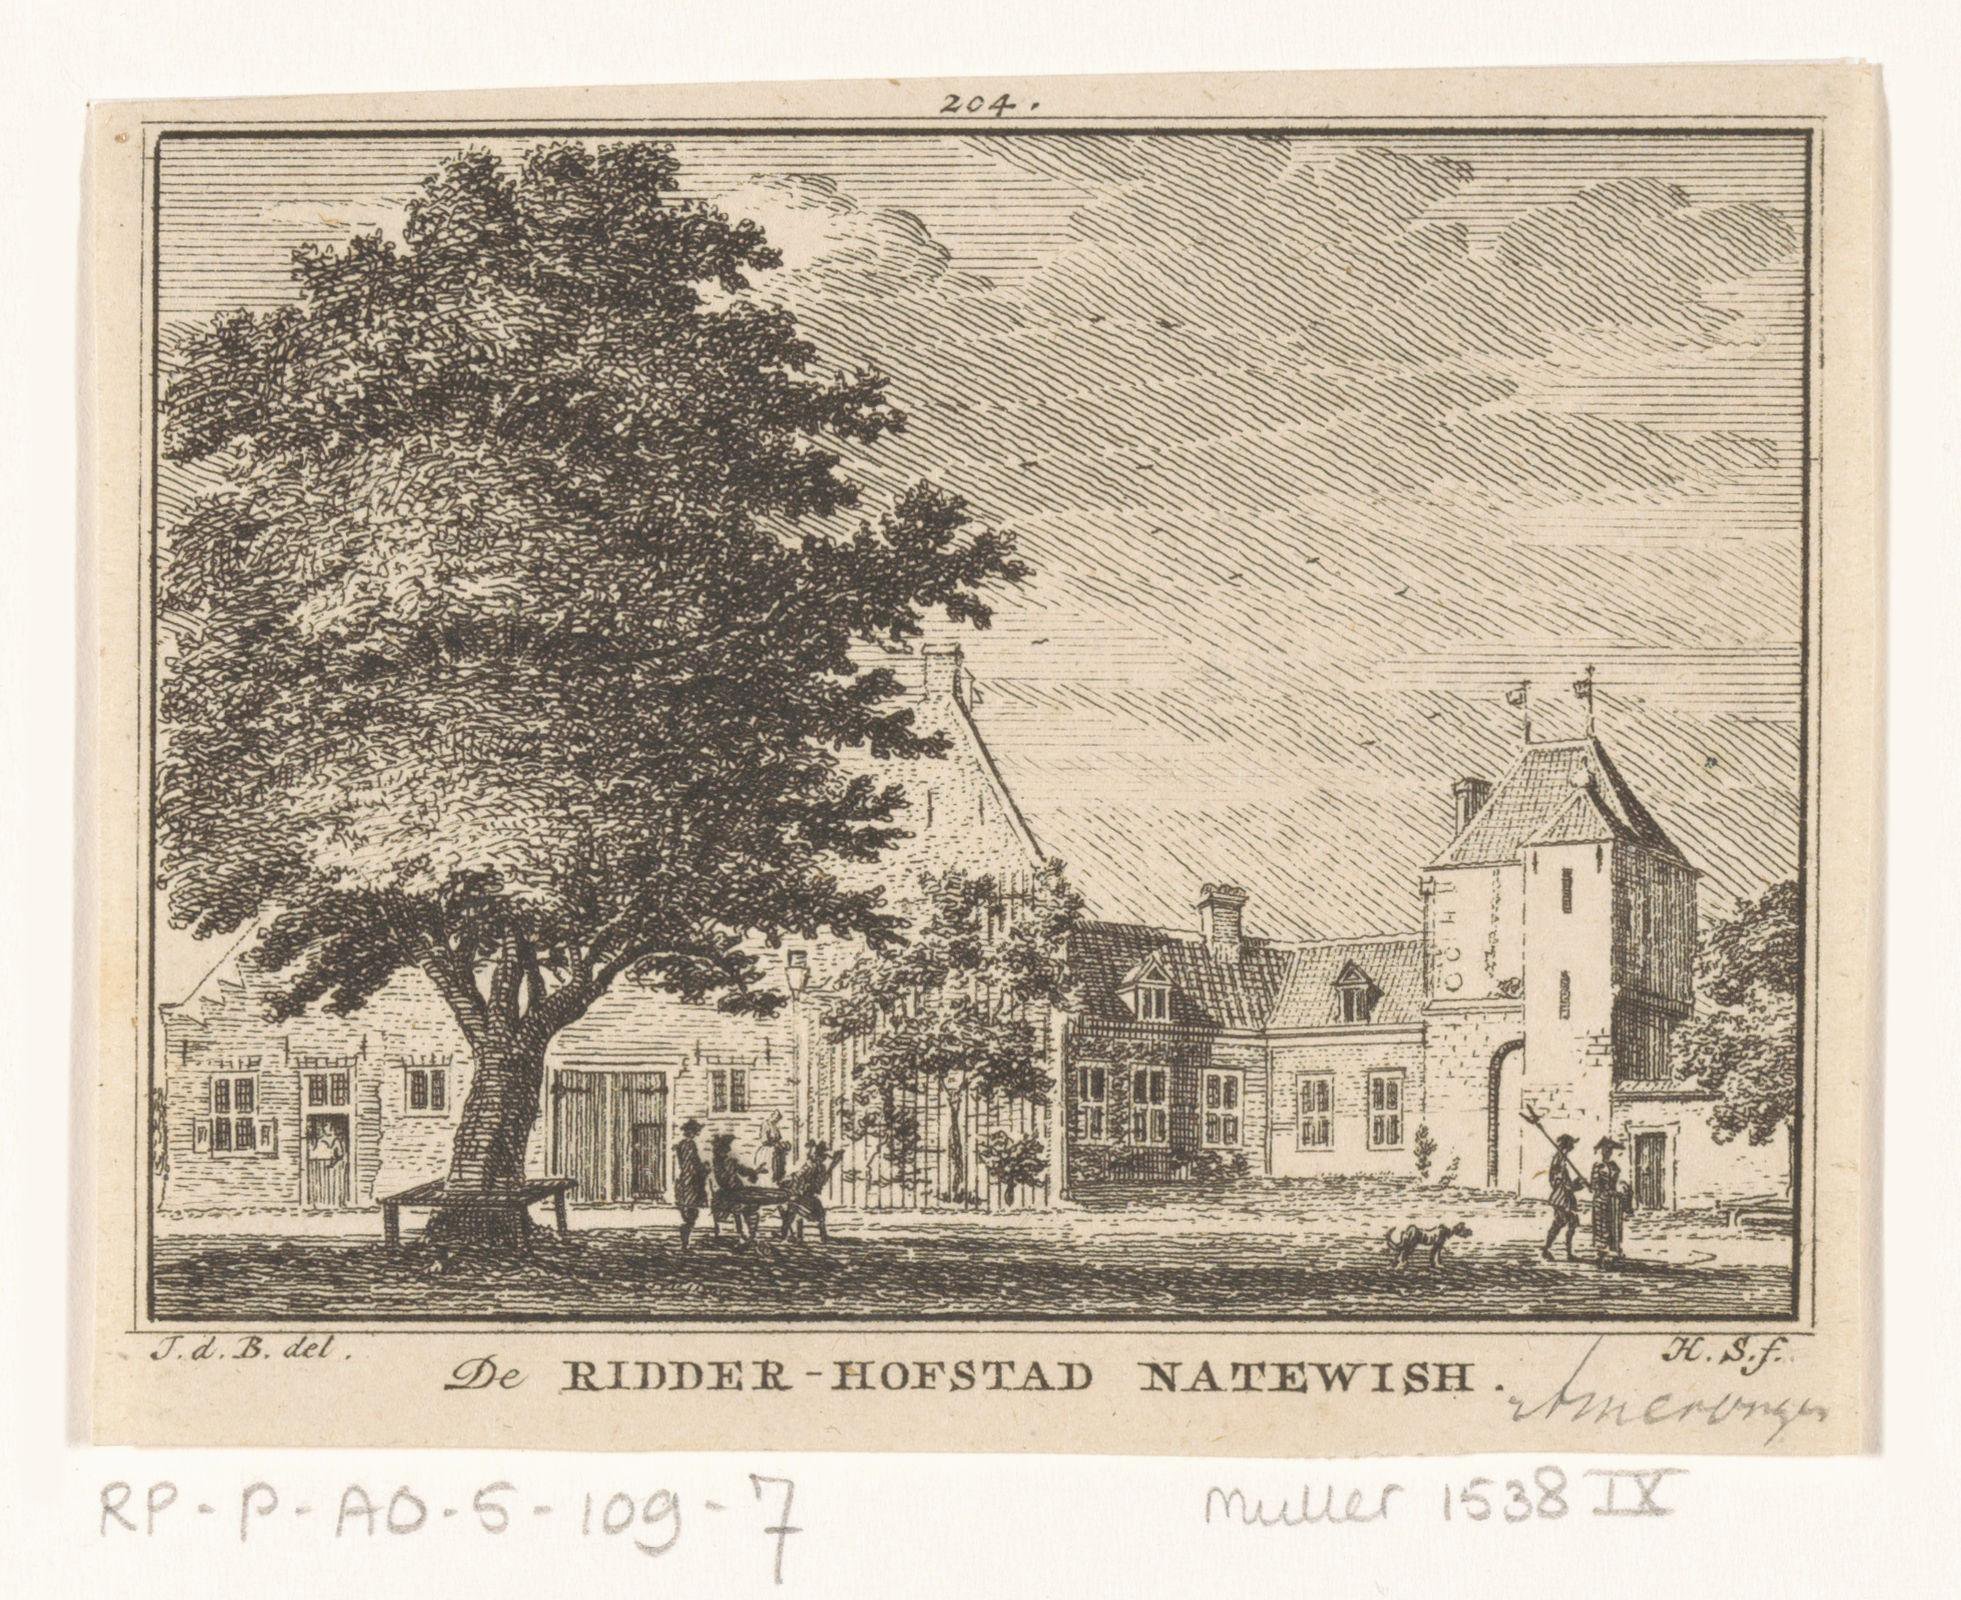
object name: print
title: Gezicht op Kasteel Natewisch te Amerongen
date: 1773-1792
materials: paper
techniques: engraving, etching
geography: haarlem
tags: castle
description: Prent ook gebruikt in: Het verheerlykt Nederland of kabinet van hedendaagsche gezigten van steden, dorpen (…). 9 delen. Amsterdam: Isaak Tirion en weduwe Isaak Tirion, 1745-1774, dl. 7, 8 of 9 (weduwe Isaak Tirion, 1773-1774), ill. 204. Of in: Nederlandsche tafereelen; of eene keurige verzameling van negen honderd fraaije gezigten van steden, dorpen, sloten, oudheden (….). 9 delen. Amsterdam: Jan de Groot, 1792, dl. 7, 8 of 9, ill. 204. Uit welke druk het huidige exemplaar precies komt is niet na te gaan.